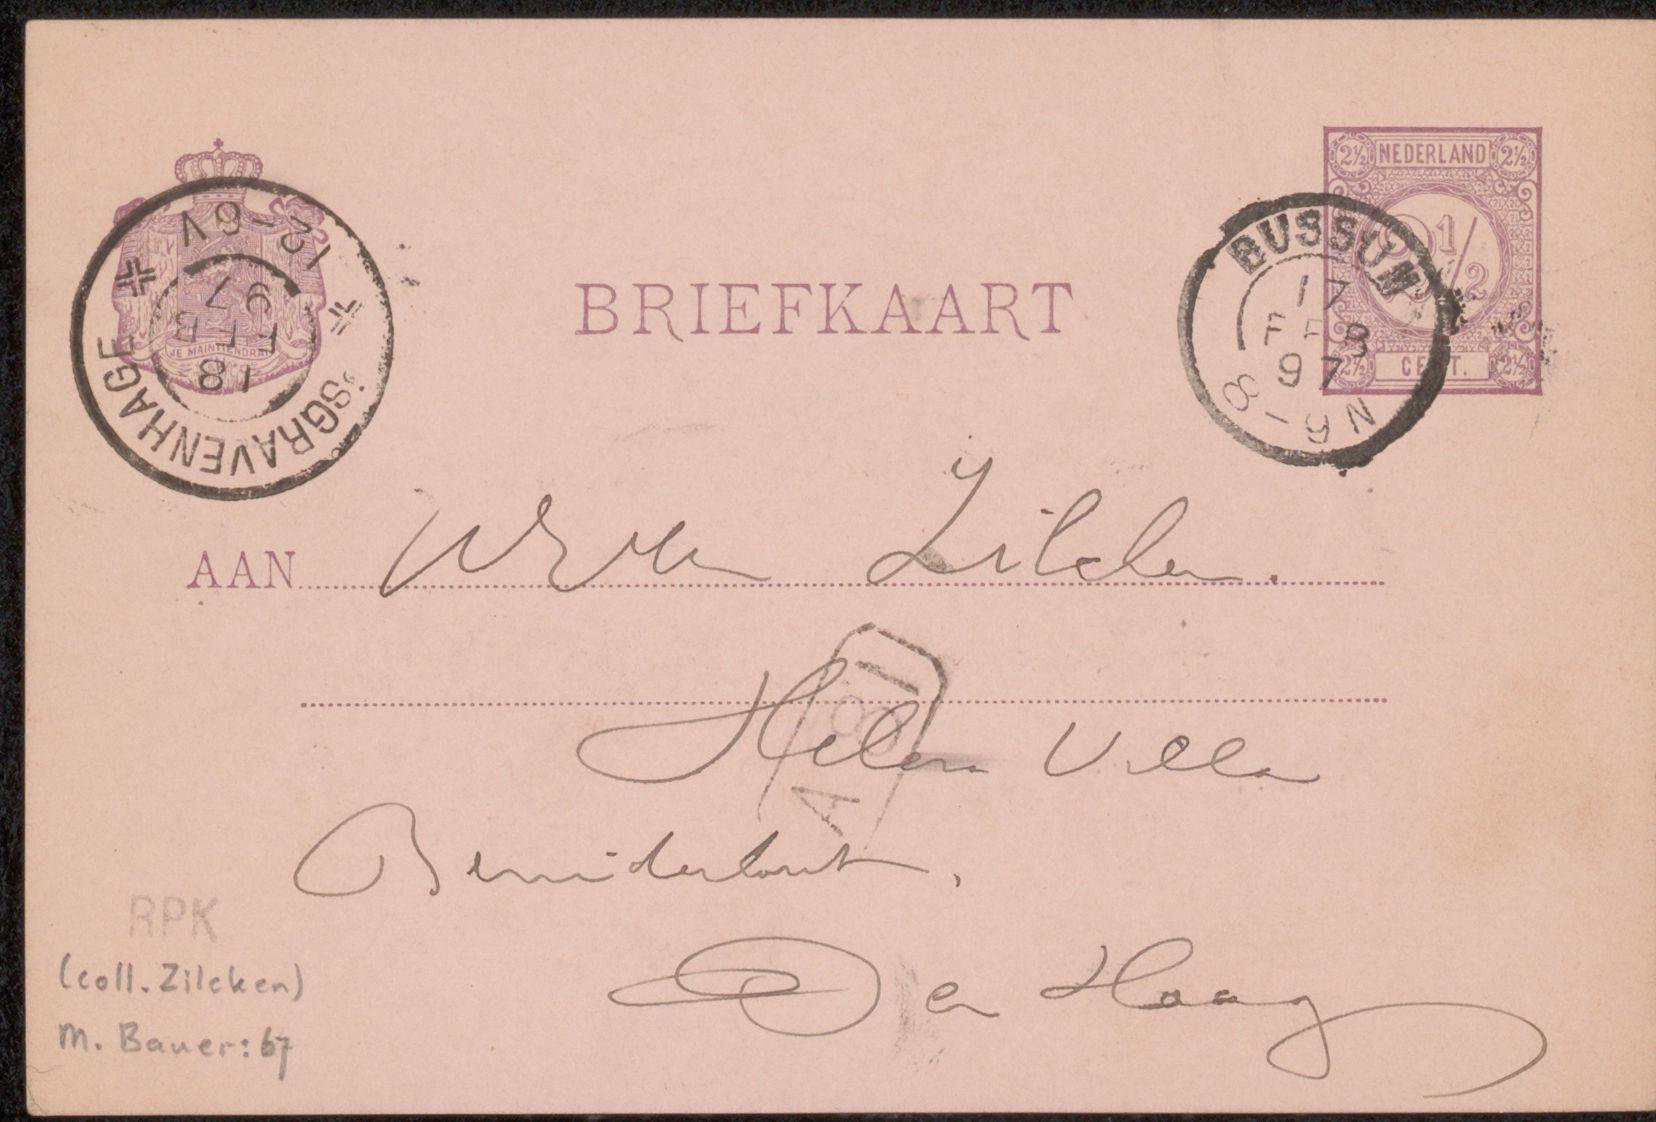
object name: postcard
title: Briefkaart aan Philip Zilcken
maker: marius bauer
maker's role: draughtsman, print maker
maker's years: 1867-1932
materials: cardboard, ink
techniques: pen, writing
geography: bussum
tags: the hague, painter, philip zilcken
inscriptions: collector's mark: ‘RPK’